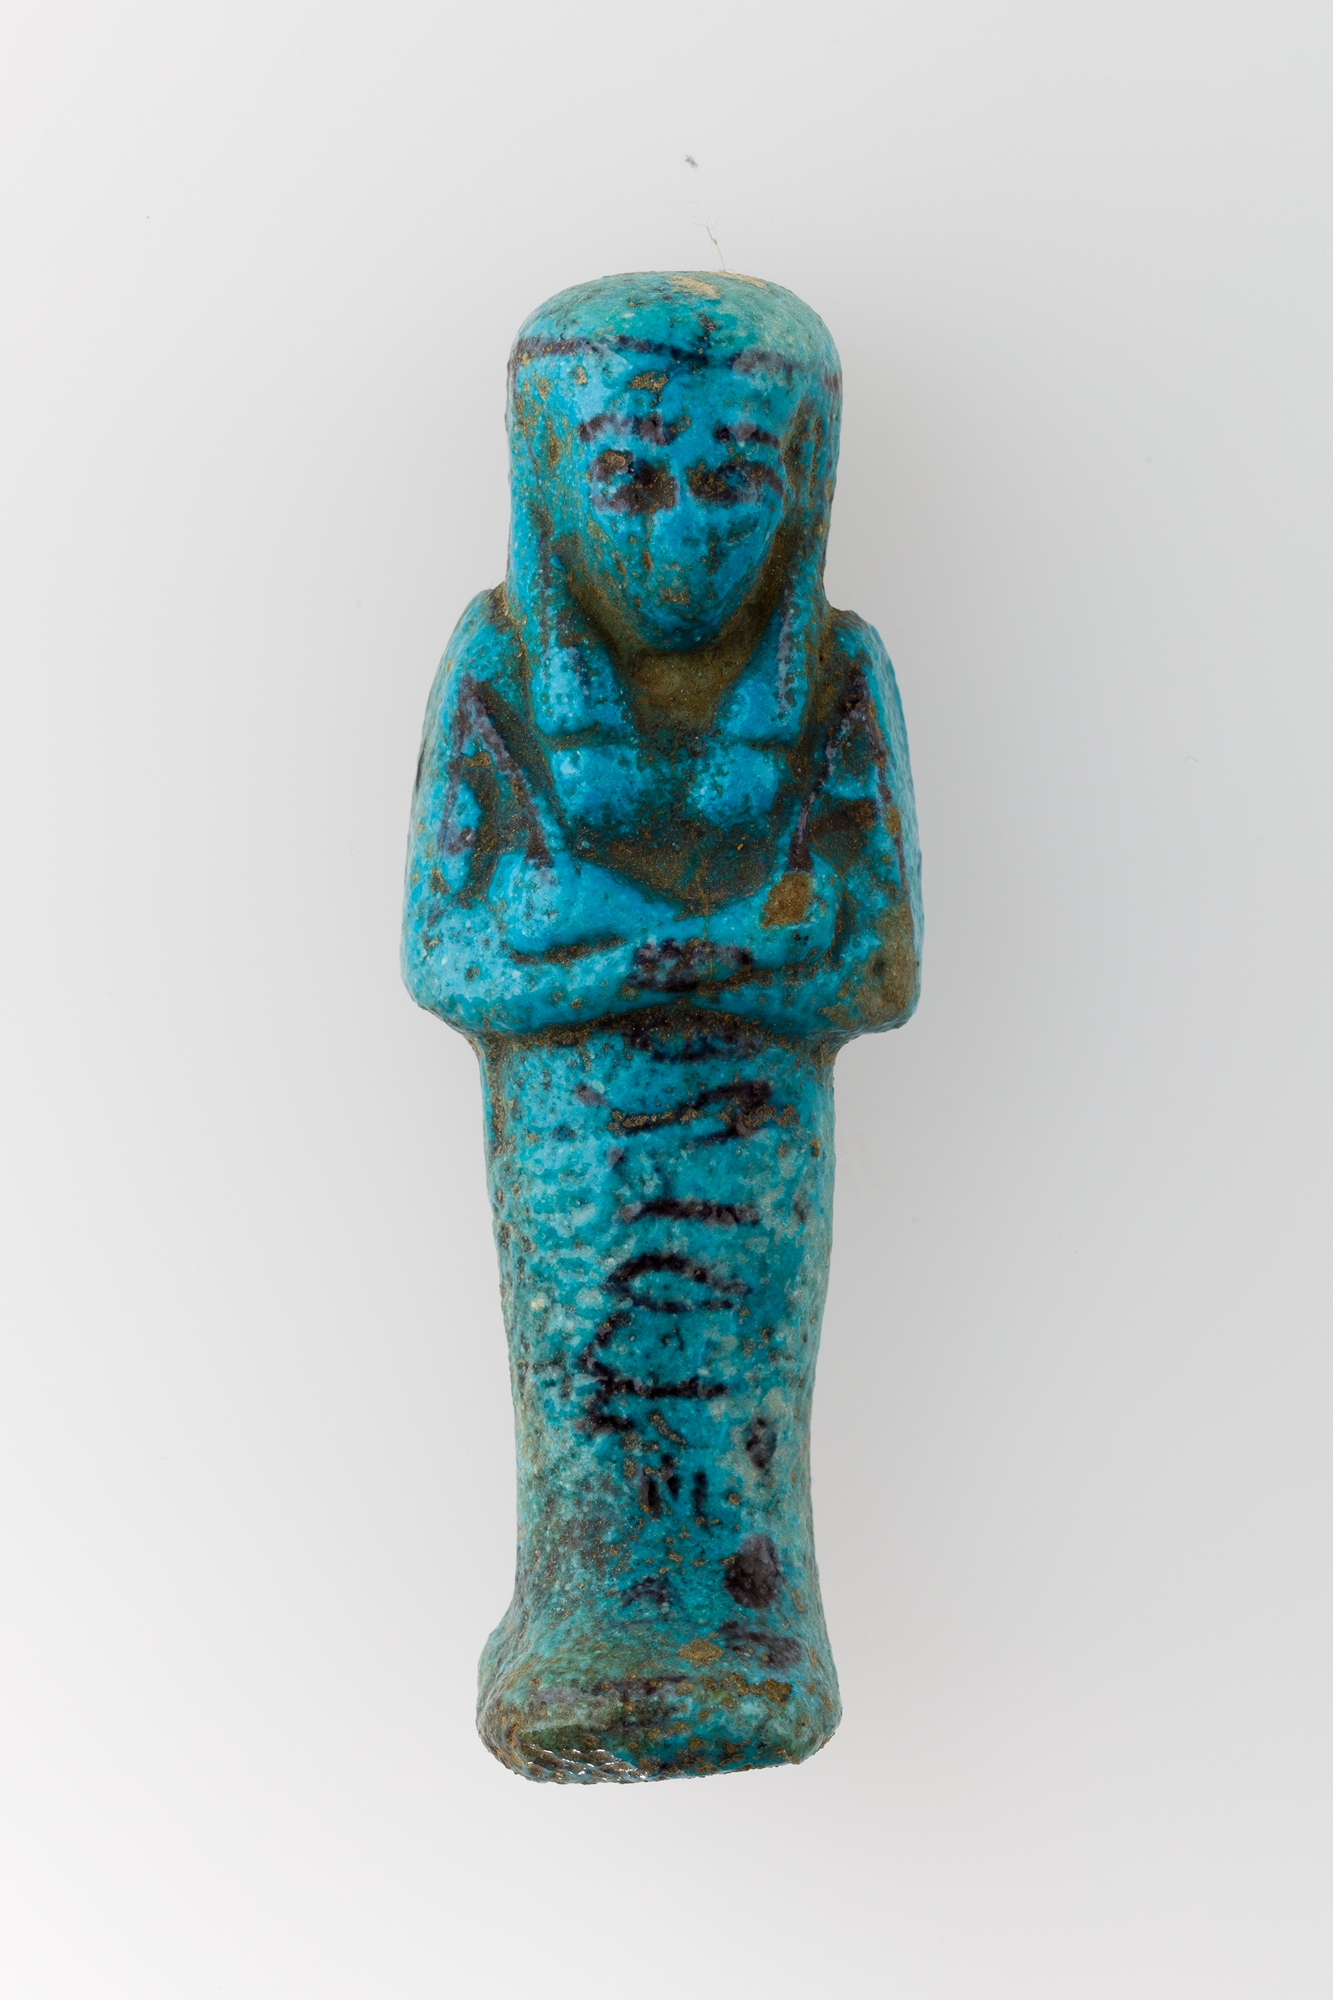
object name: shabti, henettawy c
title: Worker Shabti of Henettawy (C), Daughter of Isetemkheb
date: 990-970 BCE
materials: faience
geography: egypt